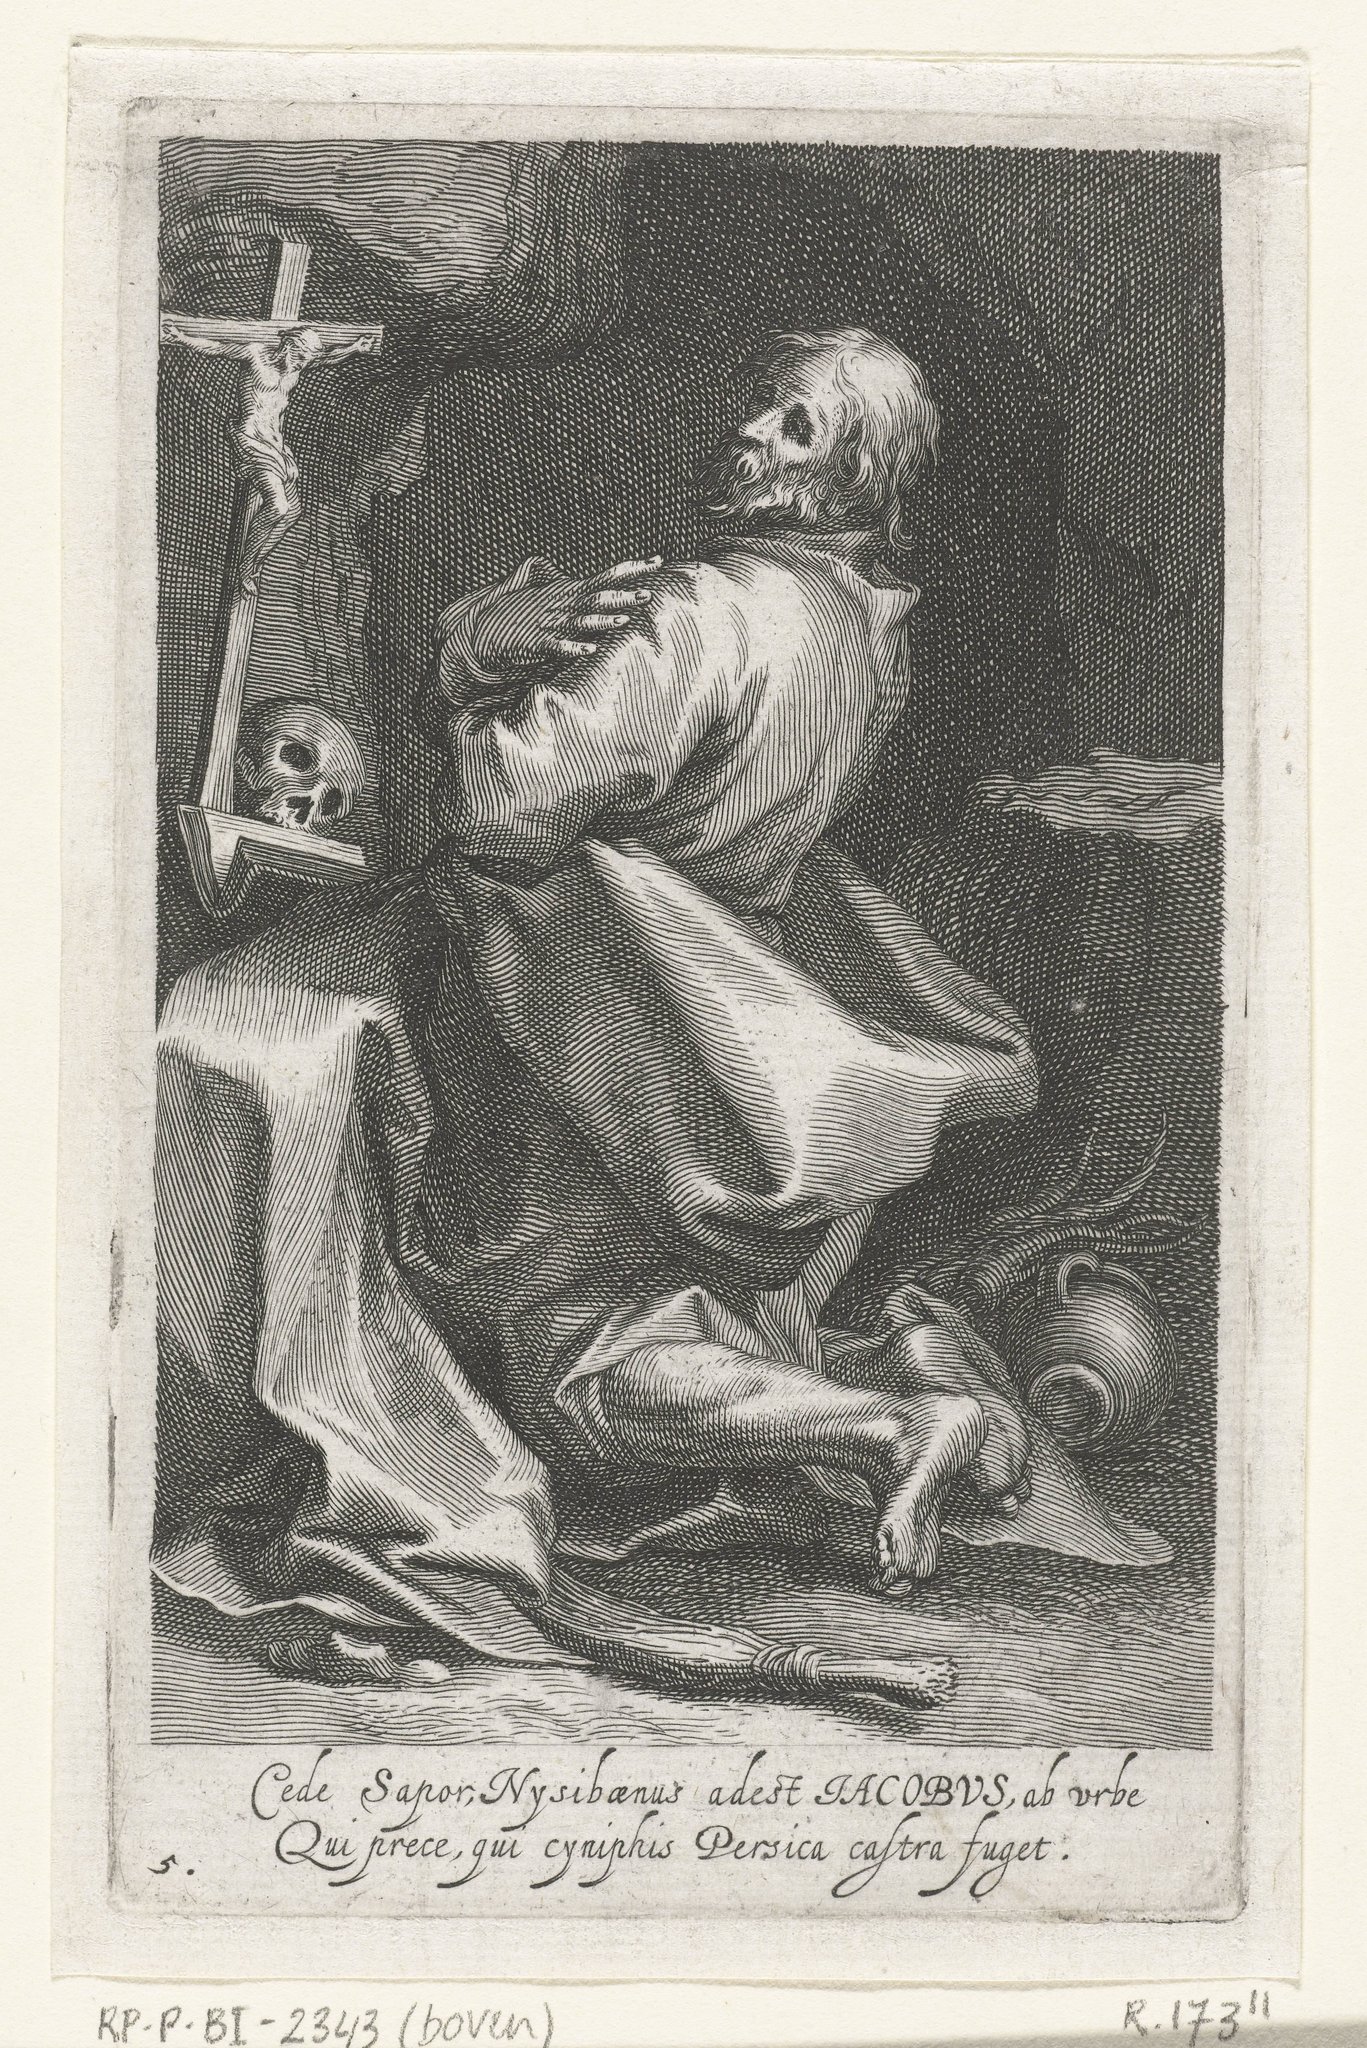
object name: print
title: Ad sacrum speculum (...) patribus dat ales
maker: boëtius adamsz. bolswert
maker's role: print maker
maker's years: 1580-1633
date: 1590-1612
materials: paper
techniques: engraving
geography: amsterdam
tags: the hermit macarius of egypt (the elder, the great); possible attributes: t-shaped staff, skull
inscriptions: collector's mark: Lugt 240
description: Prent uit: Ad sacrum speculum recurris? ... patribus dat ales, geen plaats, Boëtius Adamsz. Bolswert, 1612. Tweede ongebonden uitgave met in totaal vijftig prenten. Prent uit serie van drieentwintig mannelijke kluizenaars. In 1619 verscheen een gebonden editie maar op basis van de gewijzigde opschriften en samenstelling wordt aangenomen dat deze prenten ook in 1612 of iets daarvoor gedrukt werden. Roethlisberger beschouwt de uitgave van 1619 als de eerste staat en de ongebonden editie van 1612 als de tweede staat (Roethlisberger 1993, p. 171, 172). Op de prent is het opschrift met de naam van de heilige gewijzigd, bij de eerste staat staat de naam van de heilige Macarius van Alexandrië vermeld.